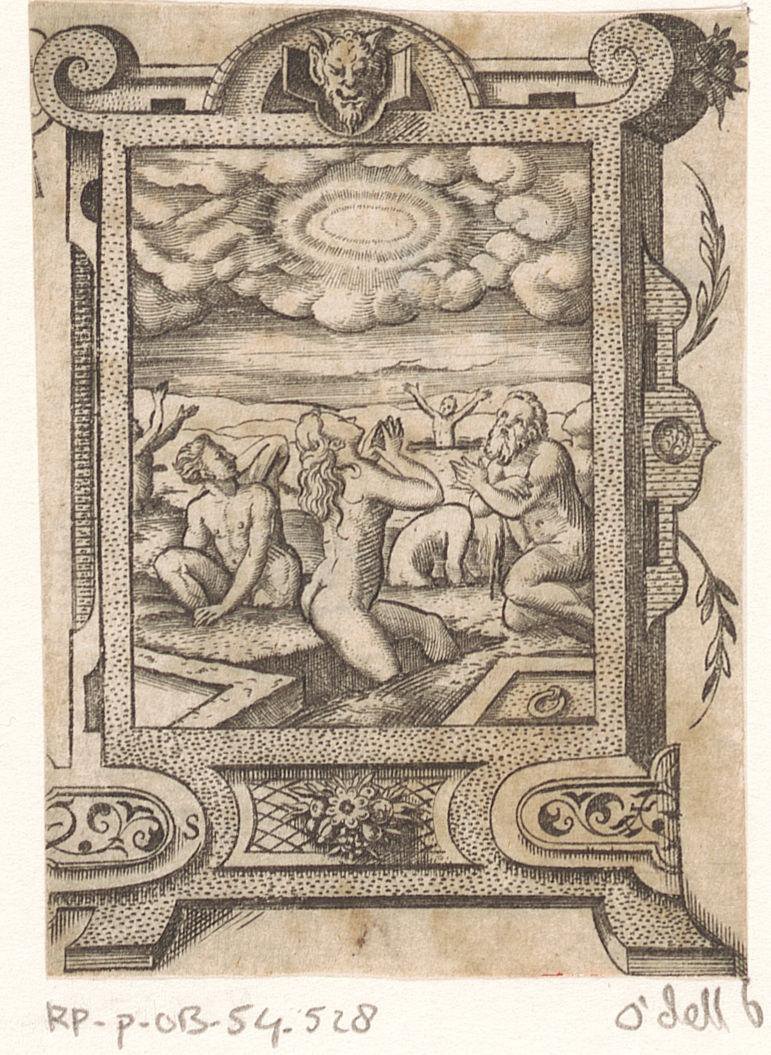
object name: print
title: Opstanding van de doden in een rolwerk omlijsting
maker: virgilius solis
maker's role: draughtsman, print maker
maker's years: 1514-1562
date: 1568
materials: paper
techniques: engraving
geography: nuremberg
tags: scrollwork, strapwork ~ ornament, resurrection of the dead ~ last judgement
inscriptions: number: ‘86’, collector's mark: Lugt 2228, collector's mark: Lugt 240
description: Prent gebruikt voor het gebedenboek: Solis, Virgil. Ein New Künstlich Betbüchlein. Neurenberg: Hieronymus Petri, 1568. Bij elke prent met een Bijbelse scène behoort een genummerde prent met een gebed in het Latijn en in het Duits. Het monogram VS is steeds verspreid over twee bij elkaar horende prenten.